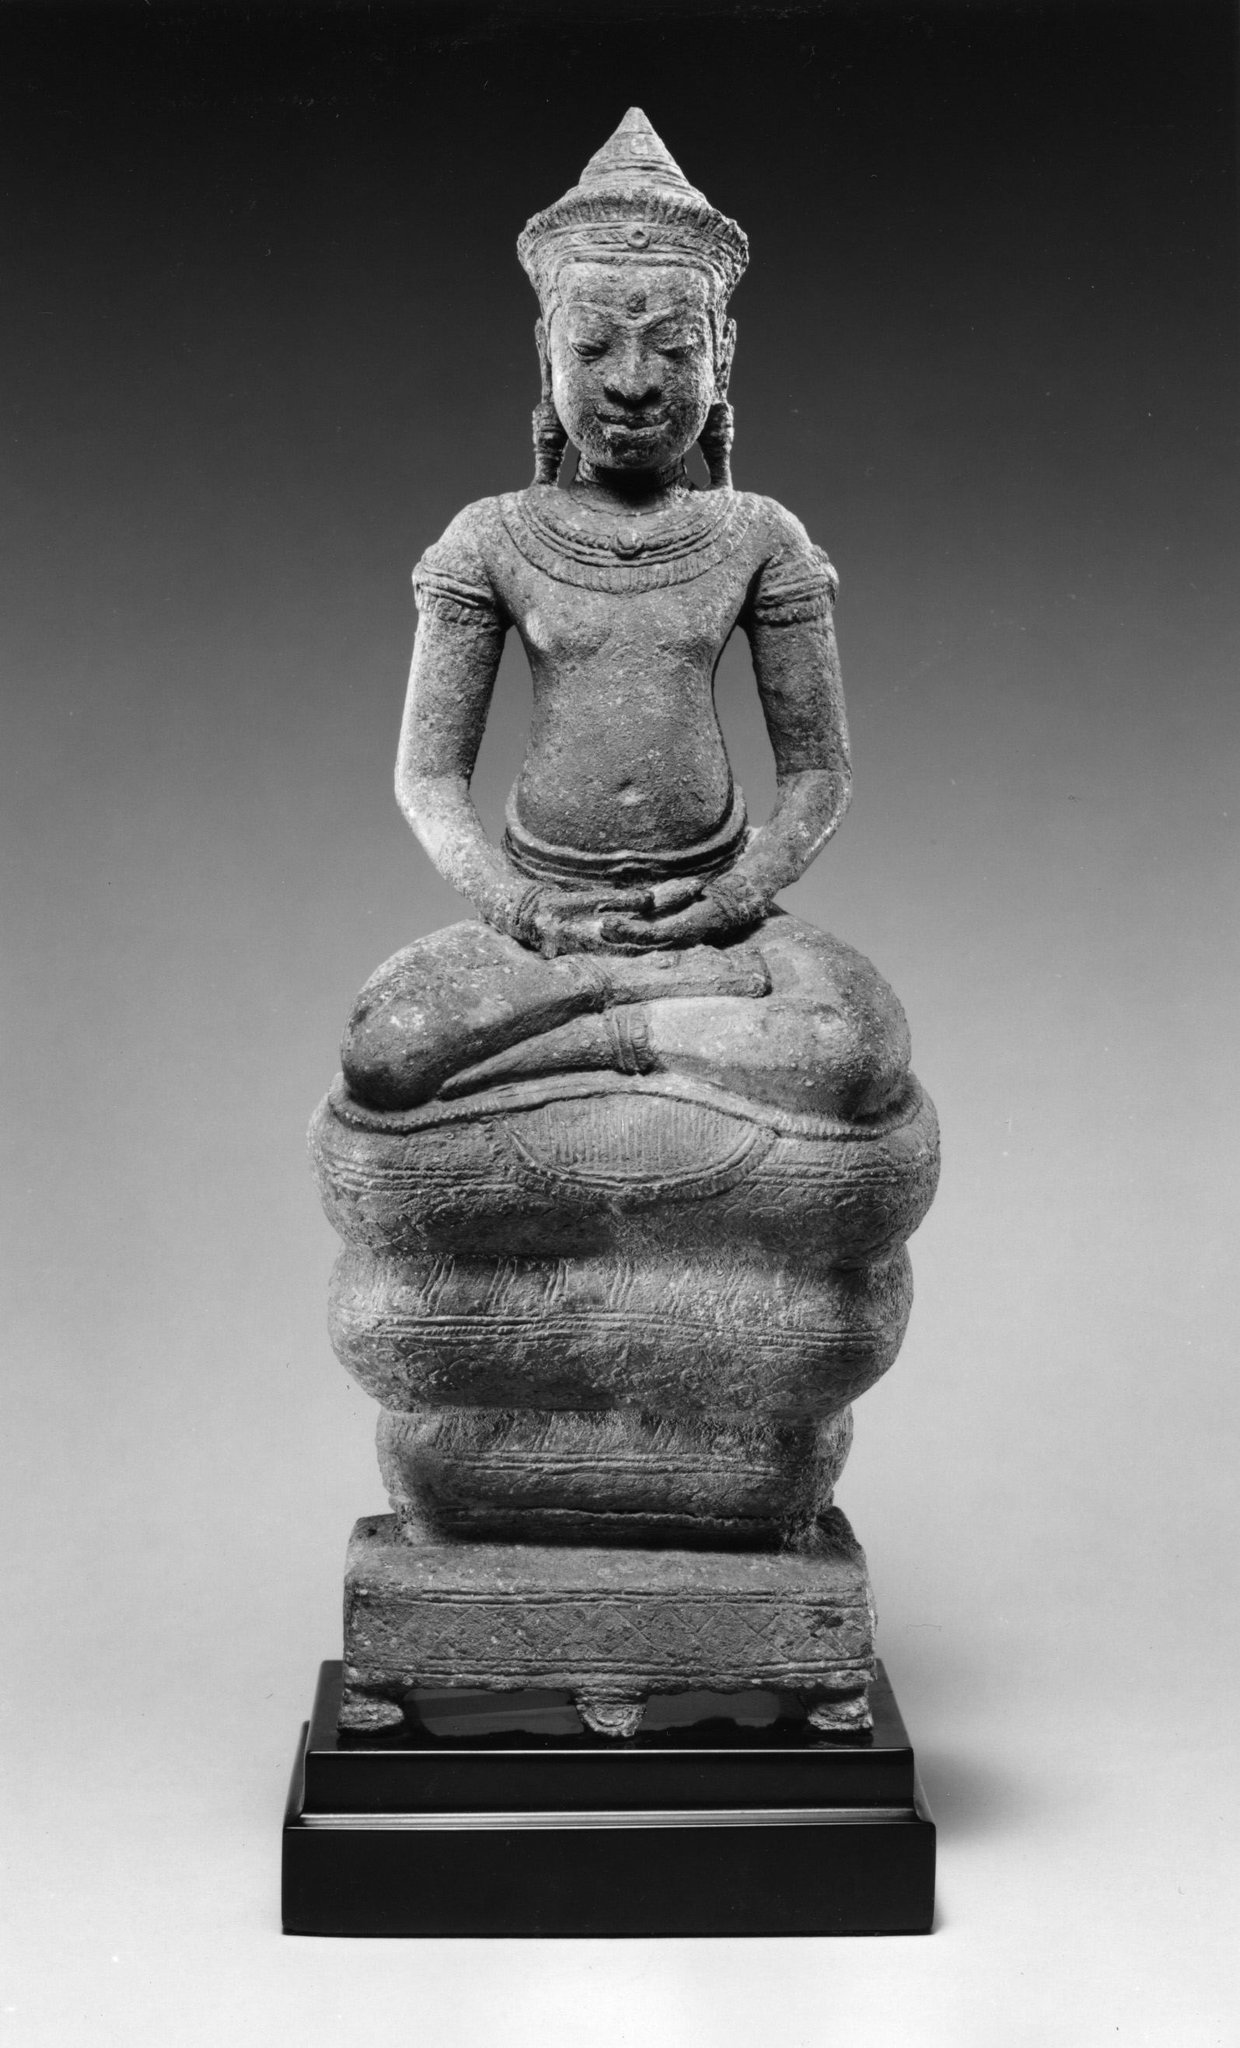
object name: figure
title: Buddha Seated on the Coils of a Naga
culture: thai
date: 1167-1200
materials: bronze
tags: buddhism,buddha